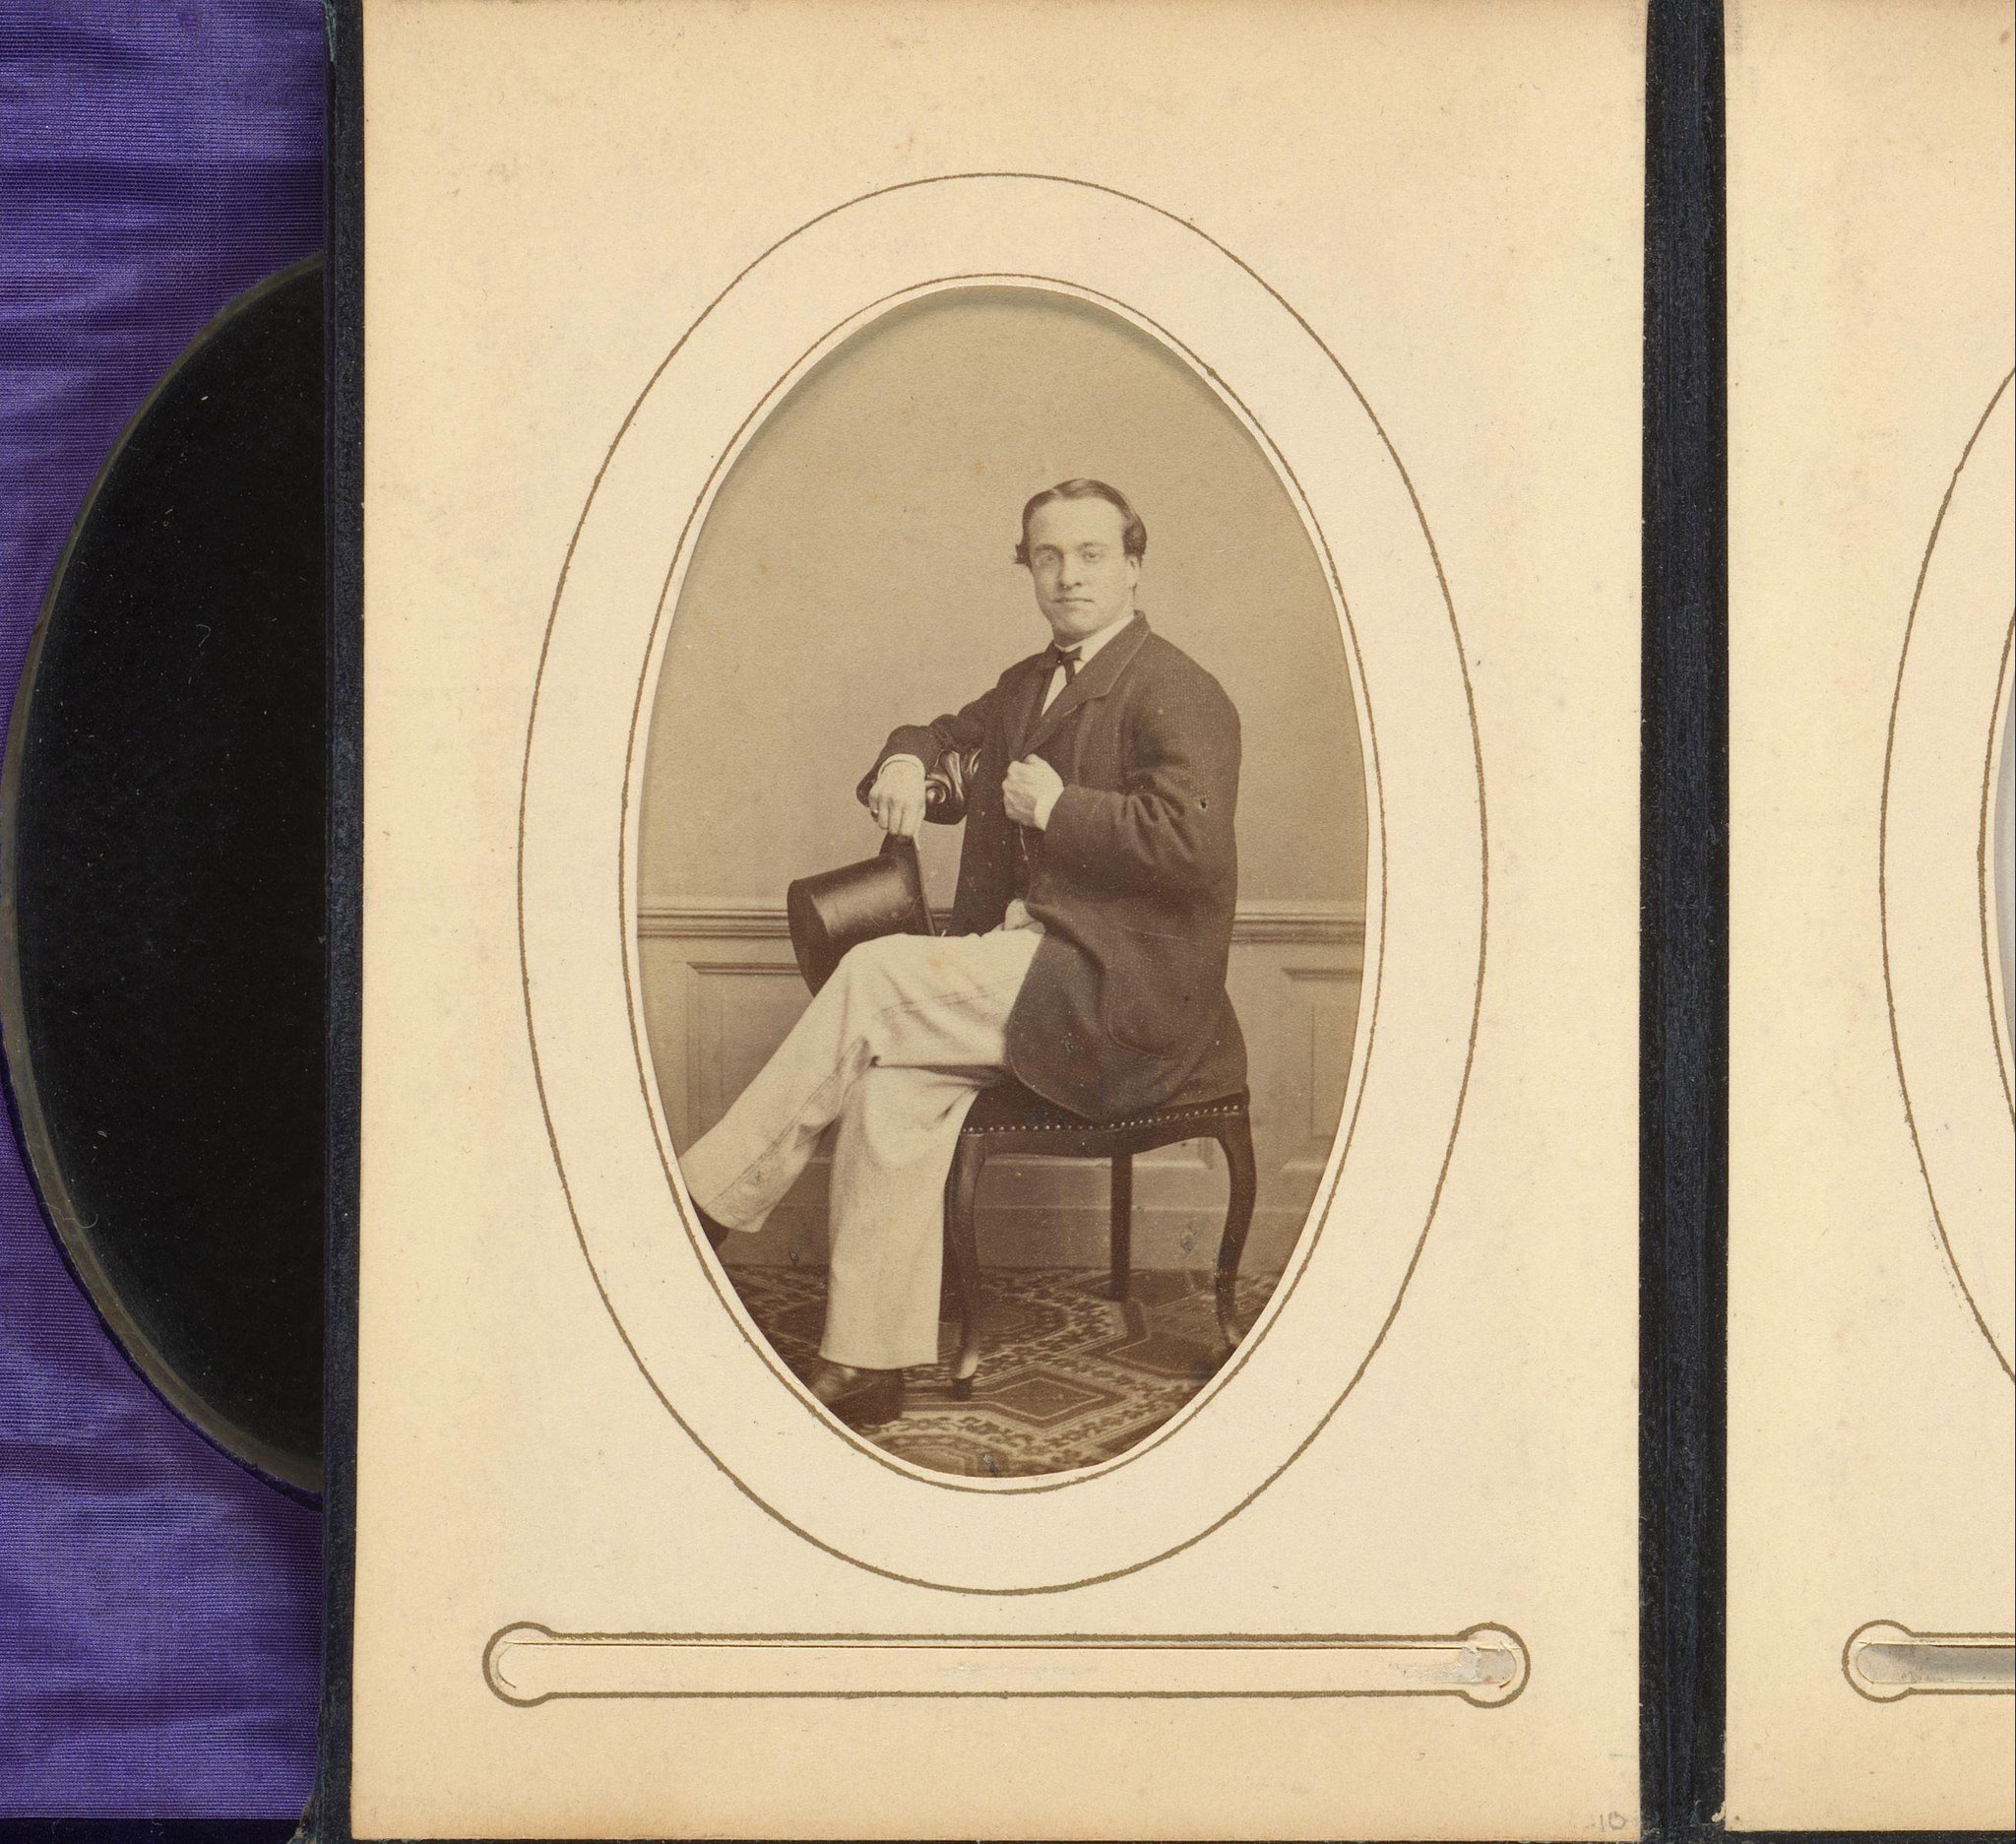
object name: carte de visite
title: Portret van een zittende man met hoge hoed in de hand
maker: gerrit hoogwinkel jr.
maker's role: fotograaf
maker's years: 1837-1890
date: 1859-1890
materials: cardboard, photographic support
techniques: albumen print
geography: rotterdam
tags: sitting figure, historical persons, head-gear: top hat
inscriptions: inscription: ‘G. HOOGWINKEL/ PHOTOGRAPHE/ ROTTERDAM’